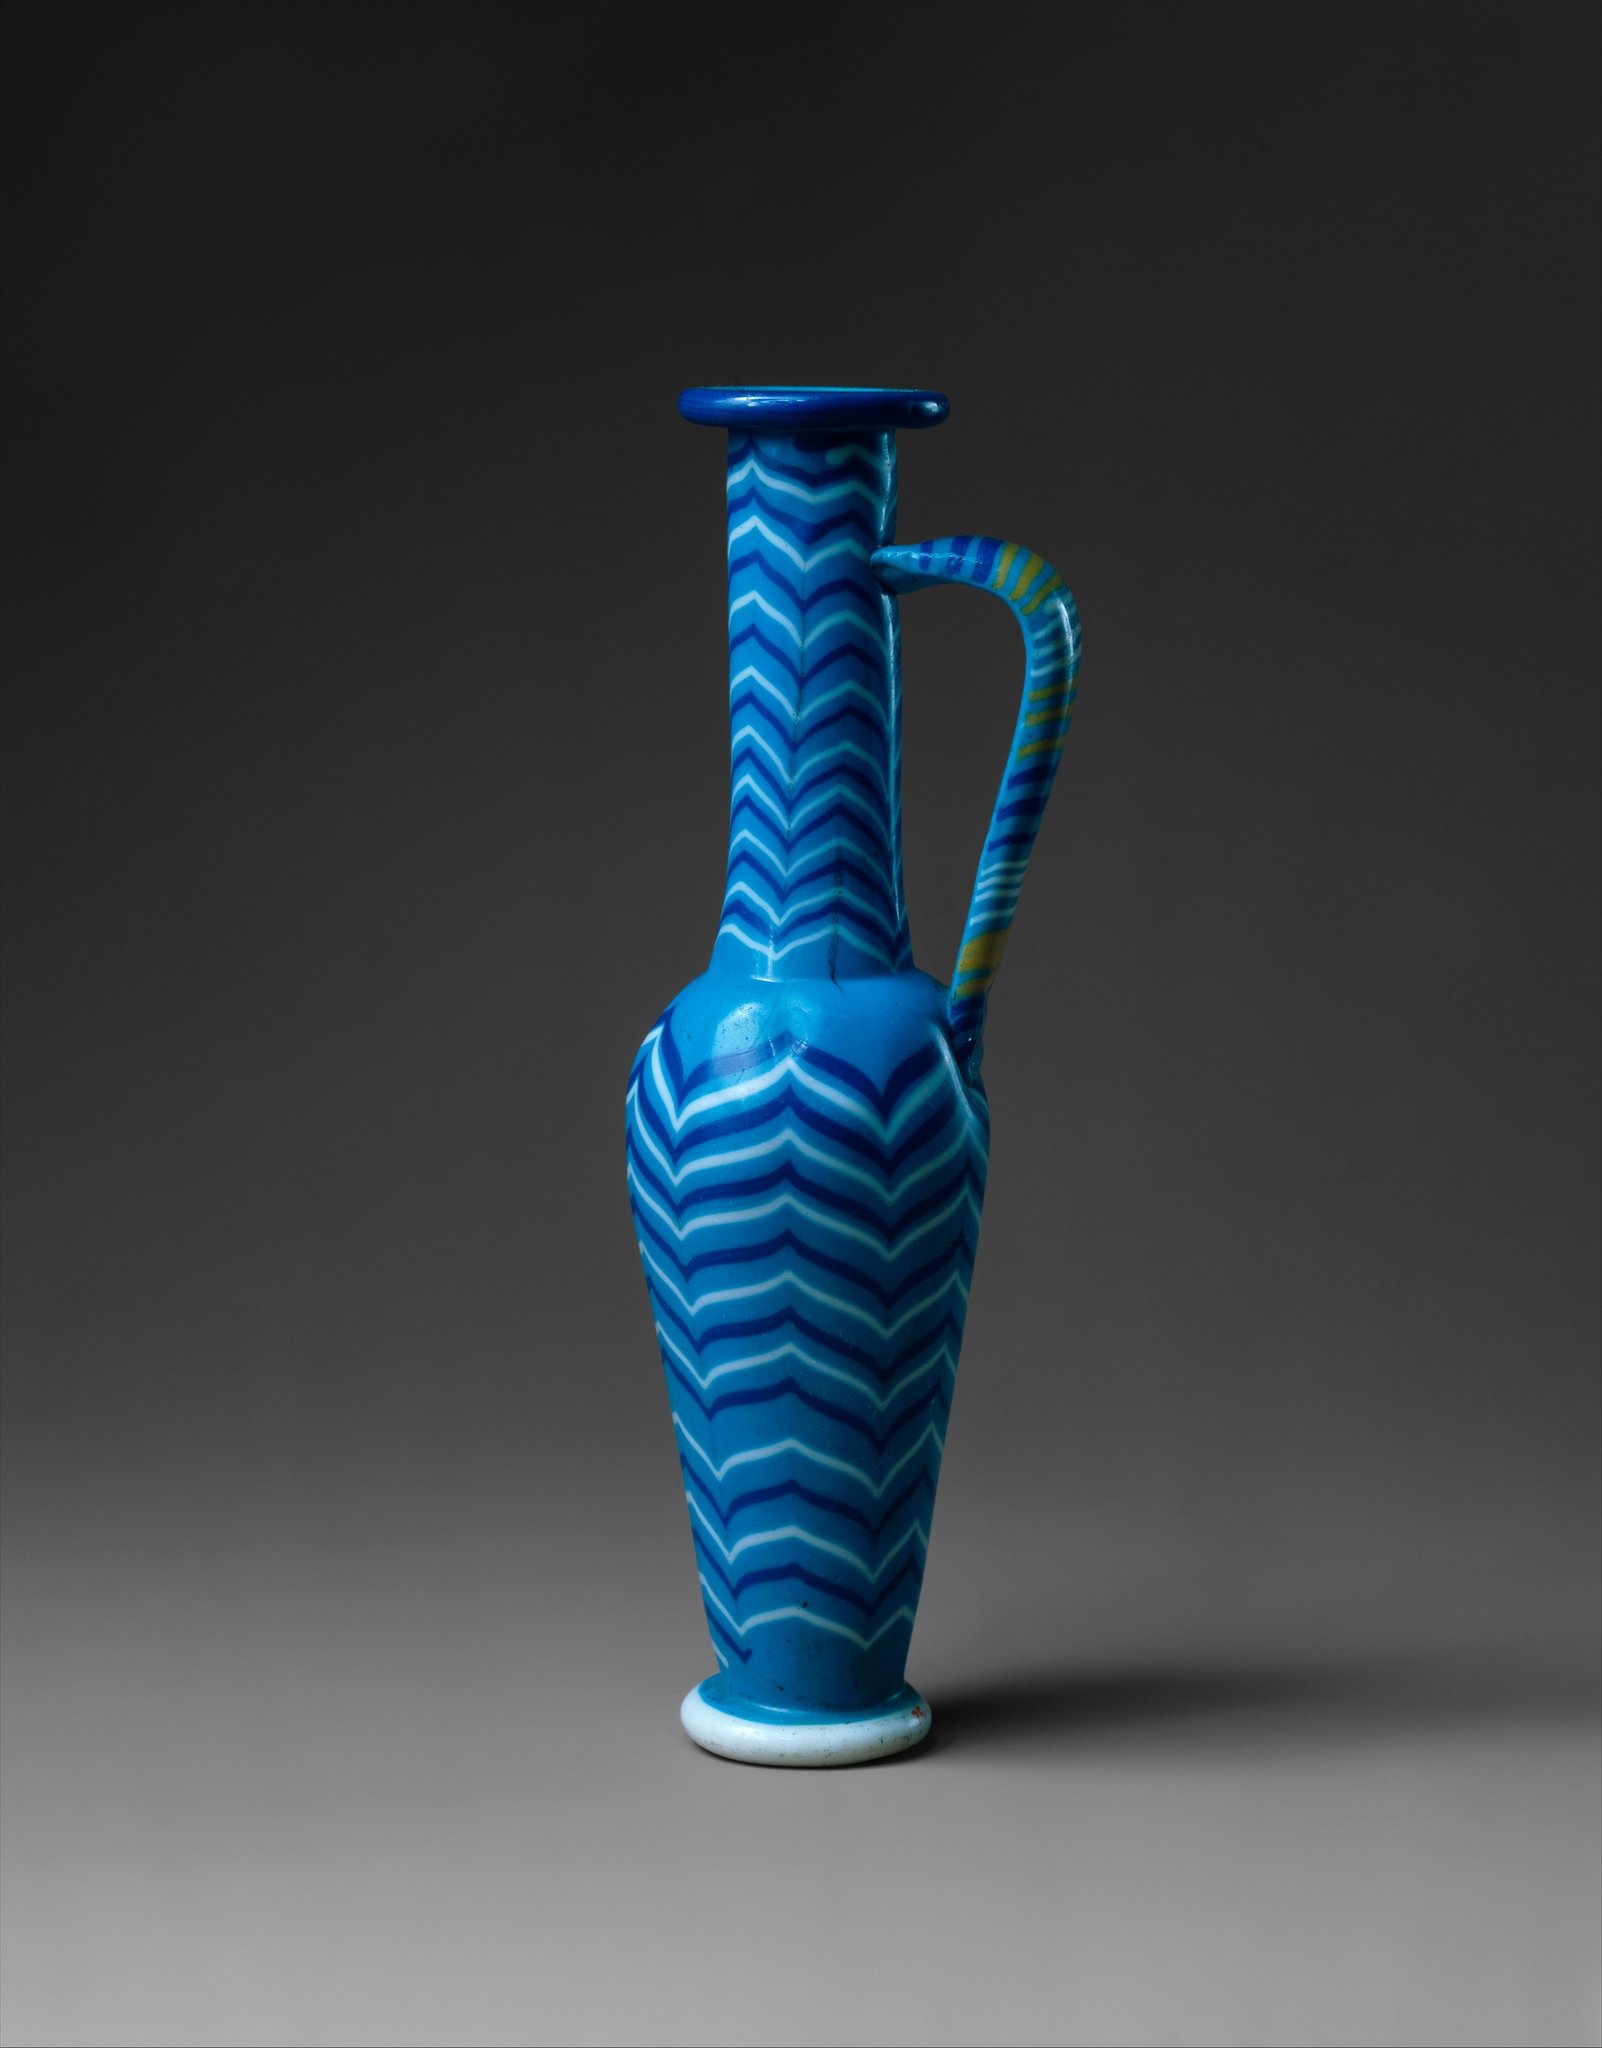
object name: bottle, spindle, handle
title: Spindle Bottle with Handle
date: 1353-1336 BCE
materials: glass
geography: middle egypt